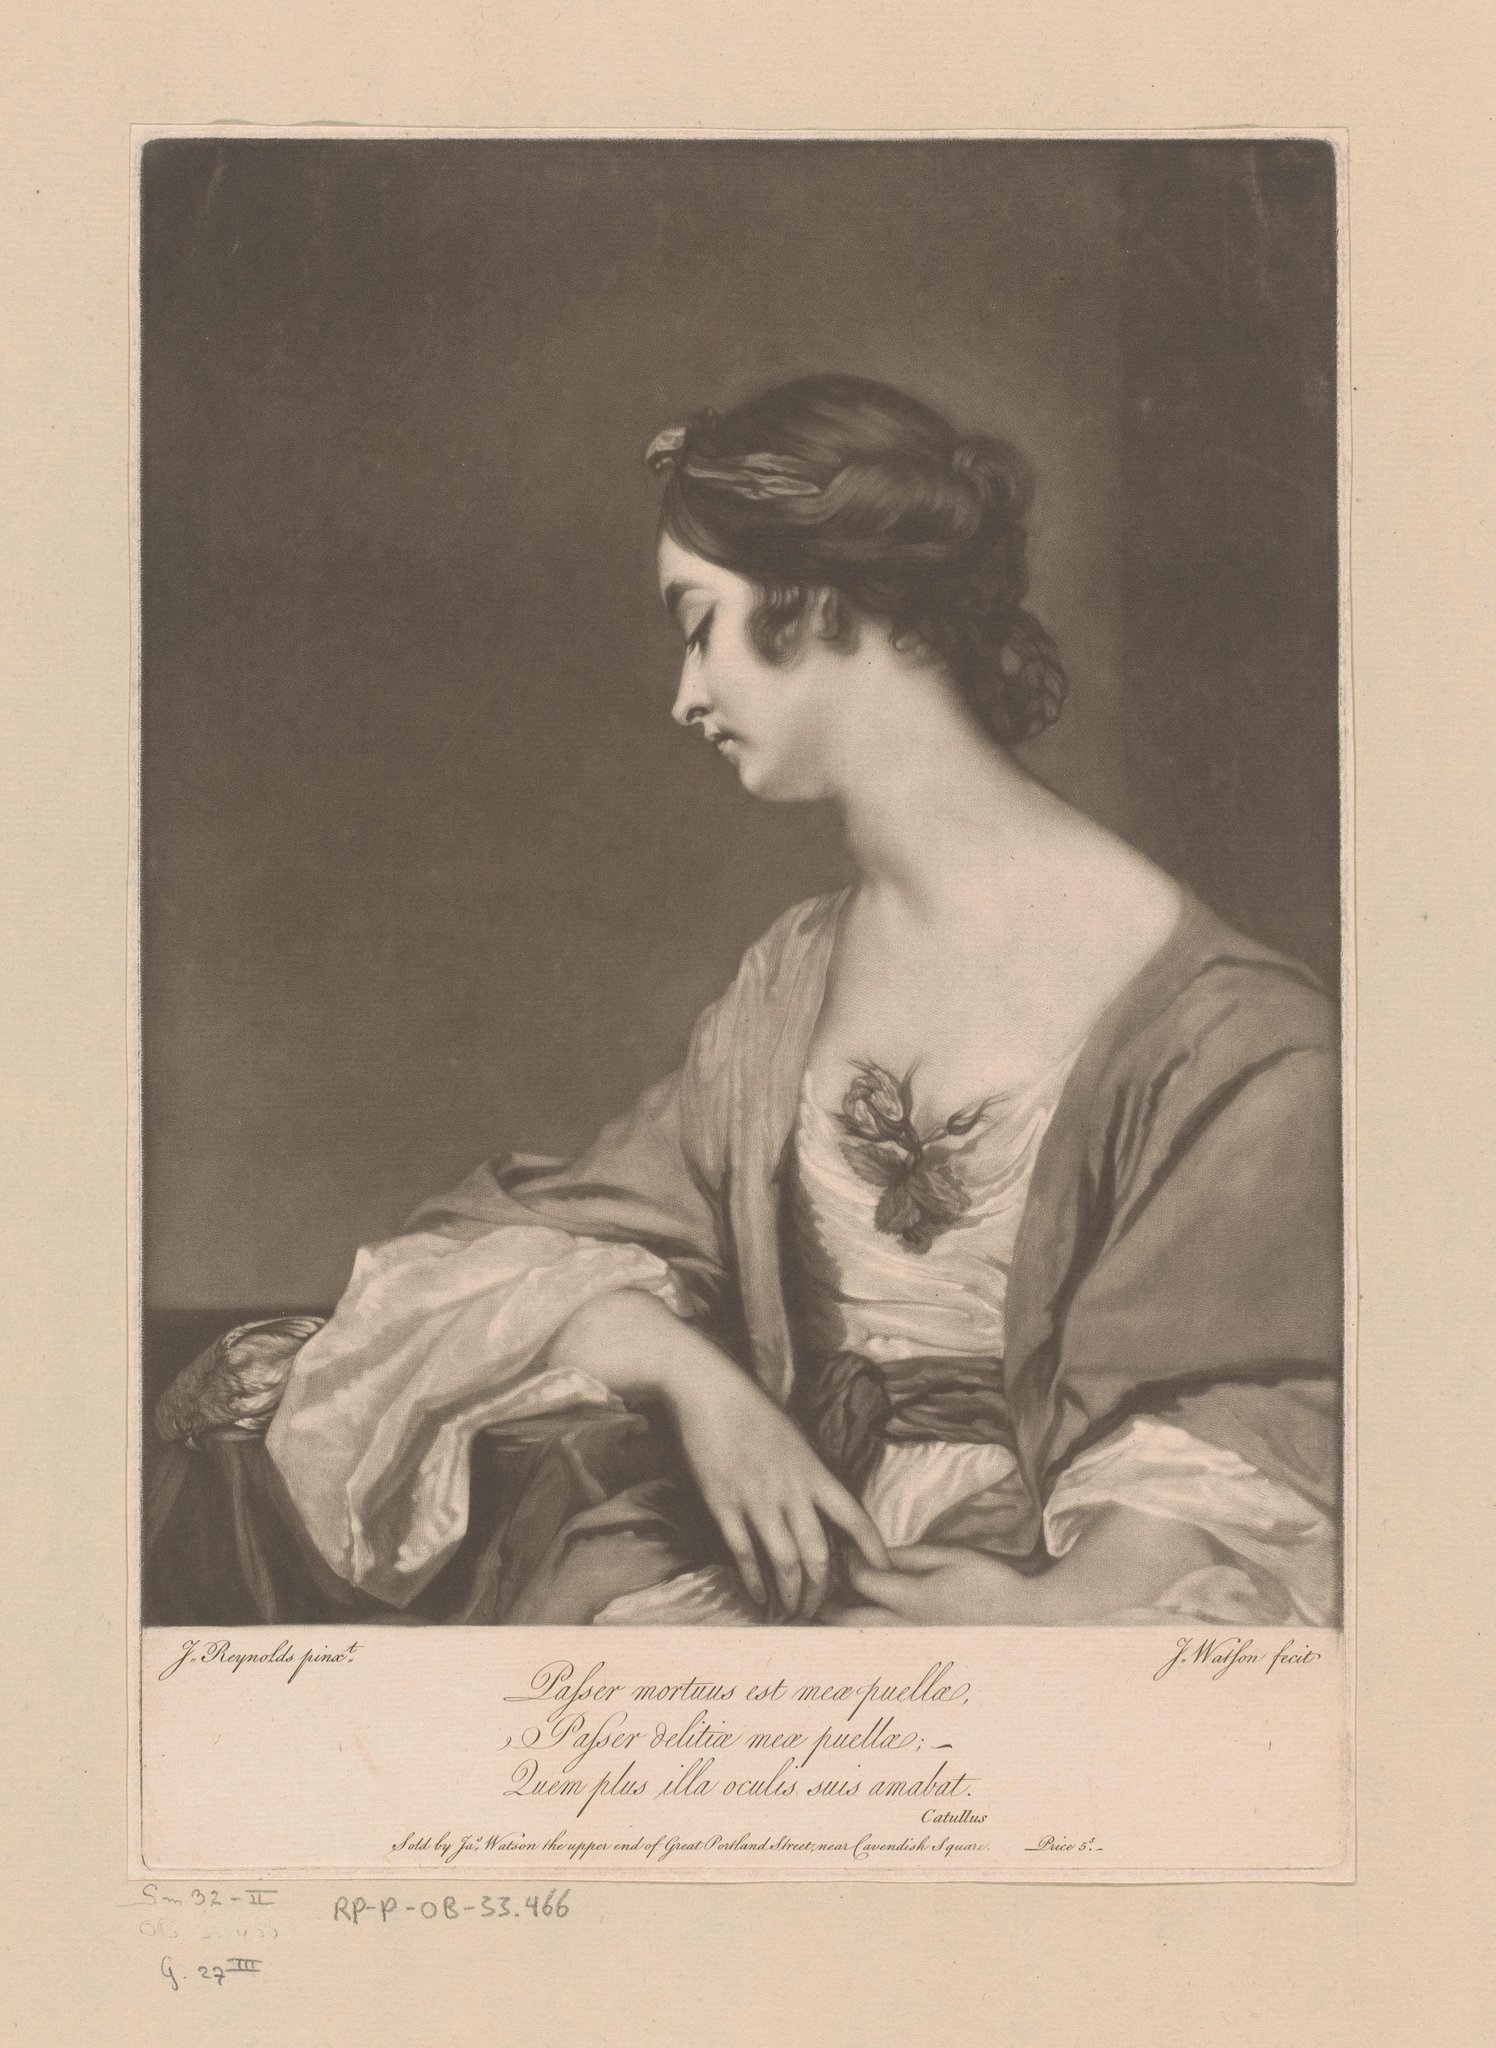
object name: print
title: Portret van Christiana Collier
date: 1764-1770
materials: paper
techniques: mezzotint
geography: london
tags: historical persons - bb - woman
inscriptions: collector's mark: Lugt 240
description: Onder de prent een drieregelig vers in het Latijn van Catullus.